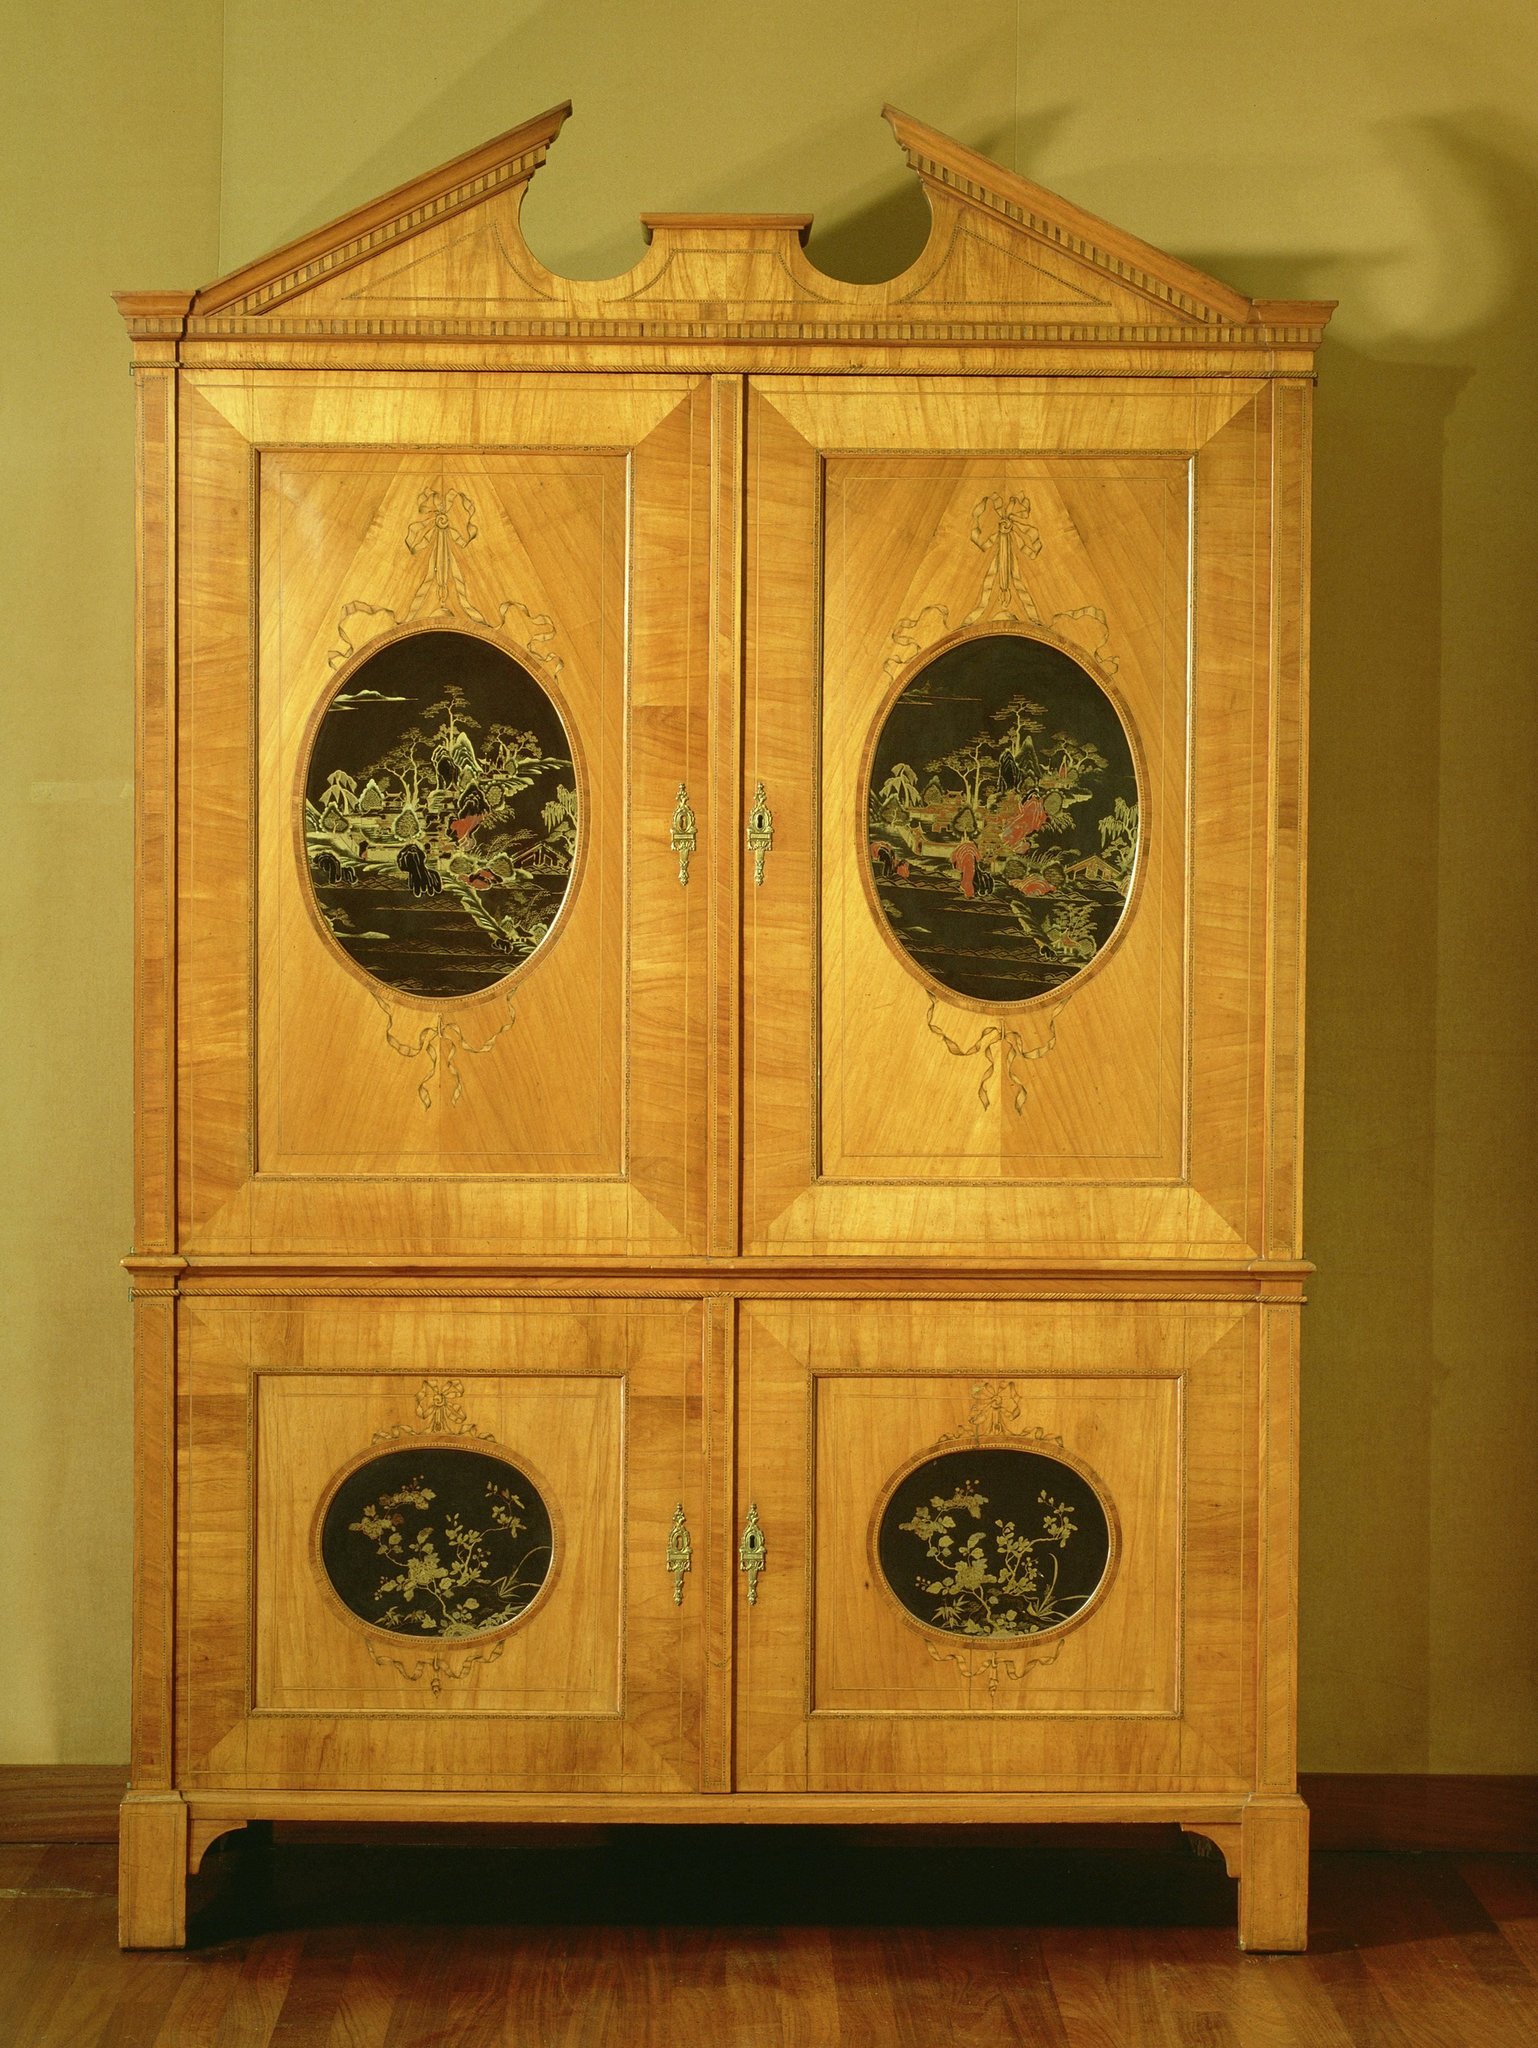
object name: furniture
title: Kast met lakpanelen aan gestrikte linten en versierd met bloemtakken en landschappen in rood en goud.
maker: Anonymous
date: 1780-1800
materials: bronze, wood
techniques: gilding, lacquer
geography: netherlands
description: Cabinet. Oak, veneered with padouk and other woods, inlaid with panels of Dutch lacquer. Netherlands, c. 1780 - 1800.